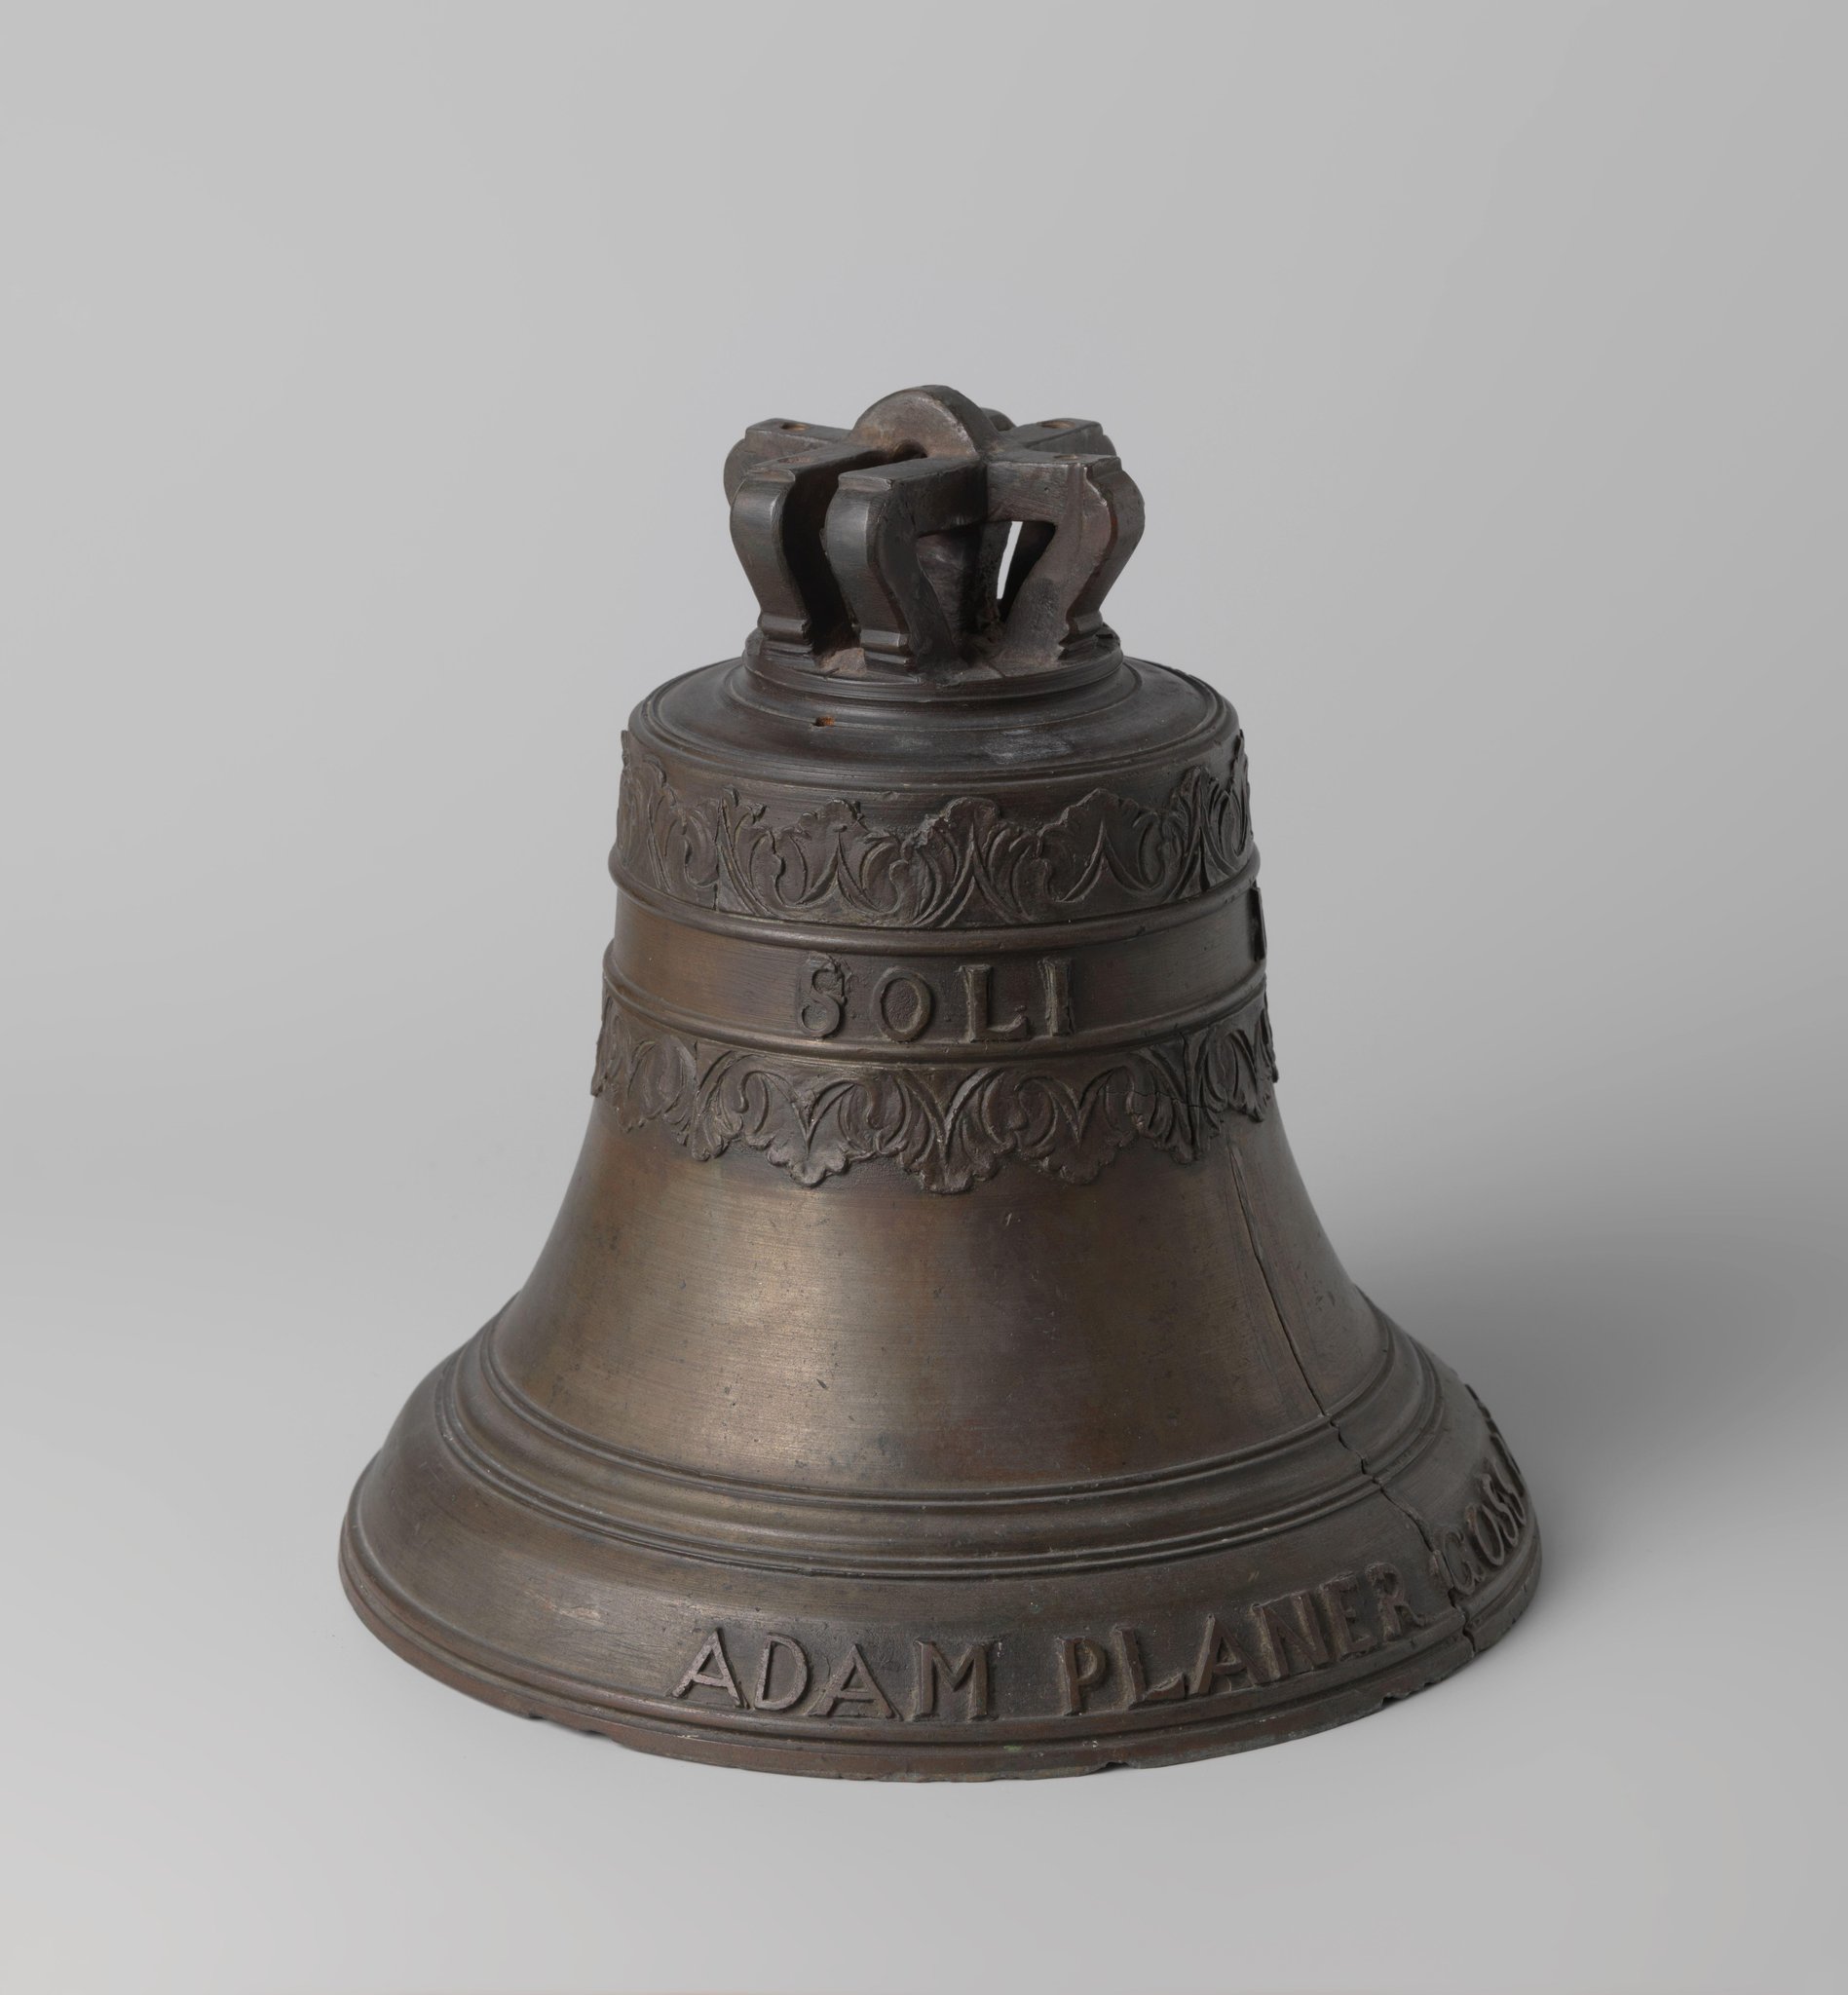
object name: bell idiophone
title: Bell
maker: adam planer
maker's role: bellfounder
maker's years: -1772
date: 1729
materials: bronze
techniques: casting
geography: lübeck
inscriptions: inscription: ‘ADAM PLANER GOSS MICH IN LYBECK ANNO 1729’, inscription: ‘SOLI DEO GLORIA’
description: Bronzen luidklok. Bovenaan een geprofileerd fries met opschrift in Latijnse majuskels: DEO GLORIA SOLI. Boven het opschrift een fries bestaande uit gestileerd rankenwerk. Onder het opschrift hetzelfde fries op zijn kop. Onderaan de rand het opschrift in Latijnse majuskels: ADAM PLANER GOSS MICH IN LYBECK ANNO 1729. Met ronde opening aan de bovenzijde. Met zesarmige kroon aan de bovenzijde.